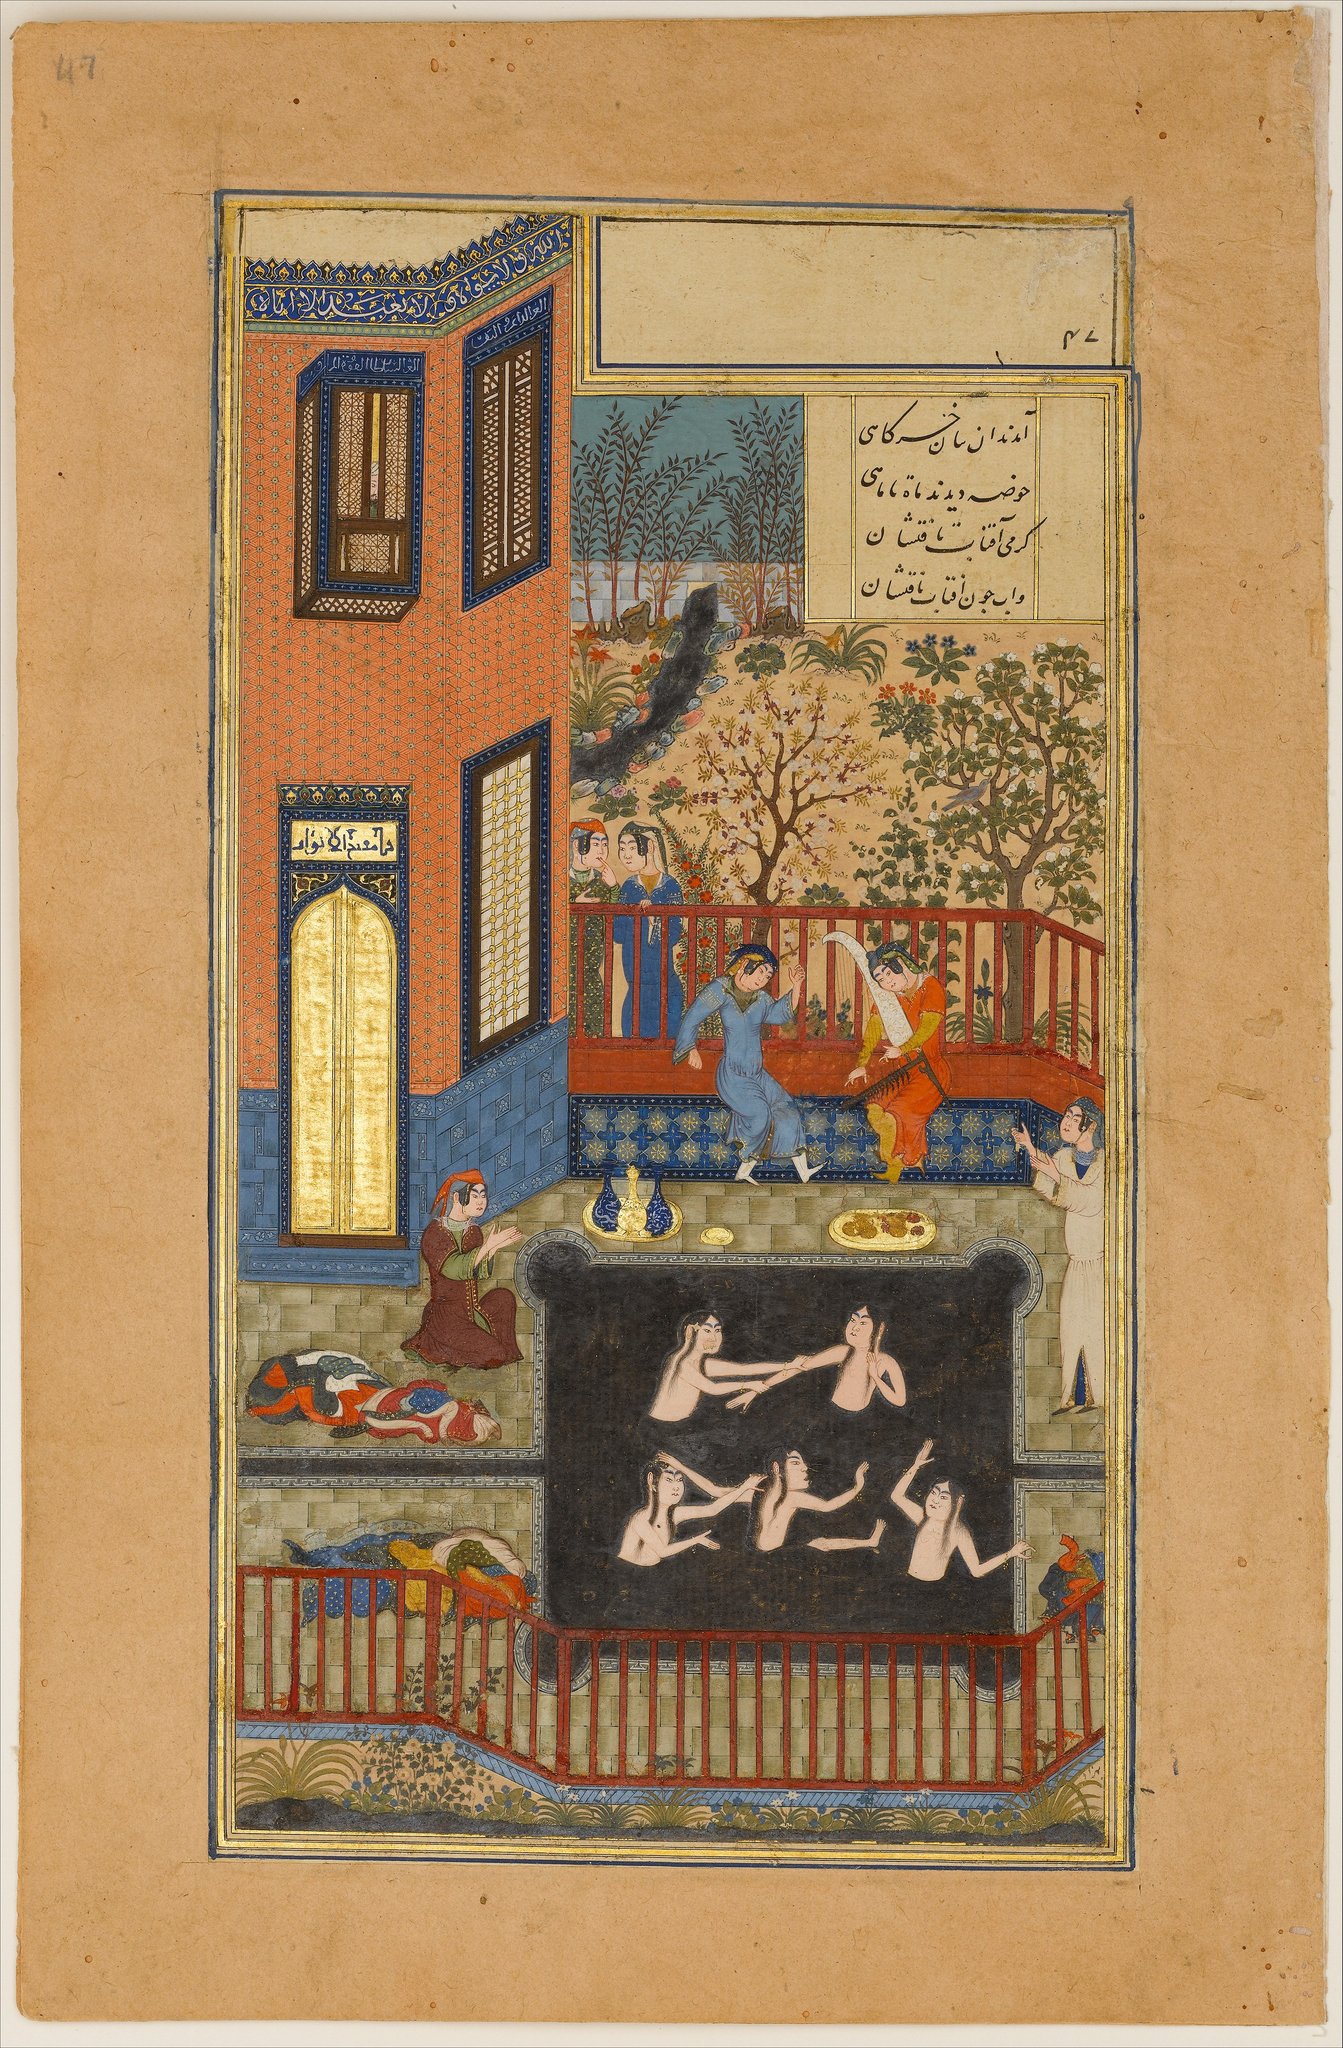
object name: folio from an illustrated manuscript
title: "The Eavesdropper", Folio 47r from a Haft Paikar (Seven Portraits) of the Khamsa (Quintet) of Nizami of Ganja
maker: maulana azhar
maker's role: calligrapher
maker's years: 1450-1501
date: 1430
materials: gold, ink, paper, silver, watercolor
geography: afghanistan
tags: musical instruments,men,women,swimming,musicians